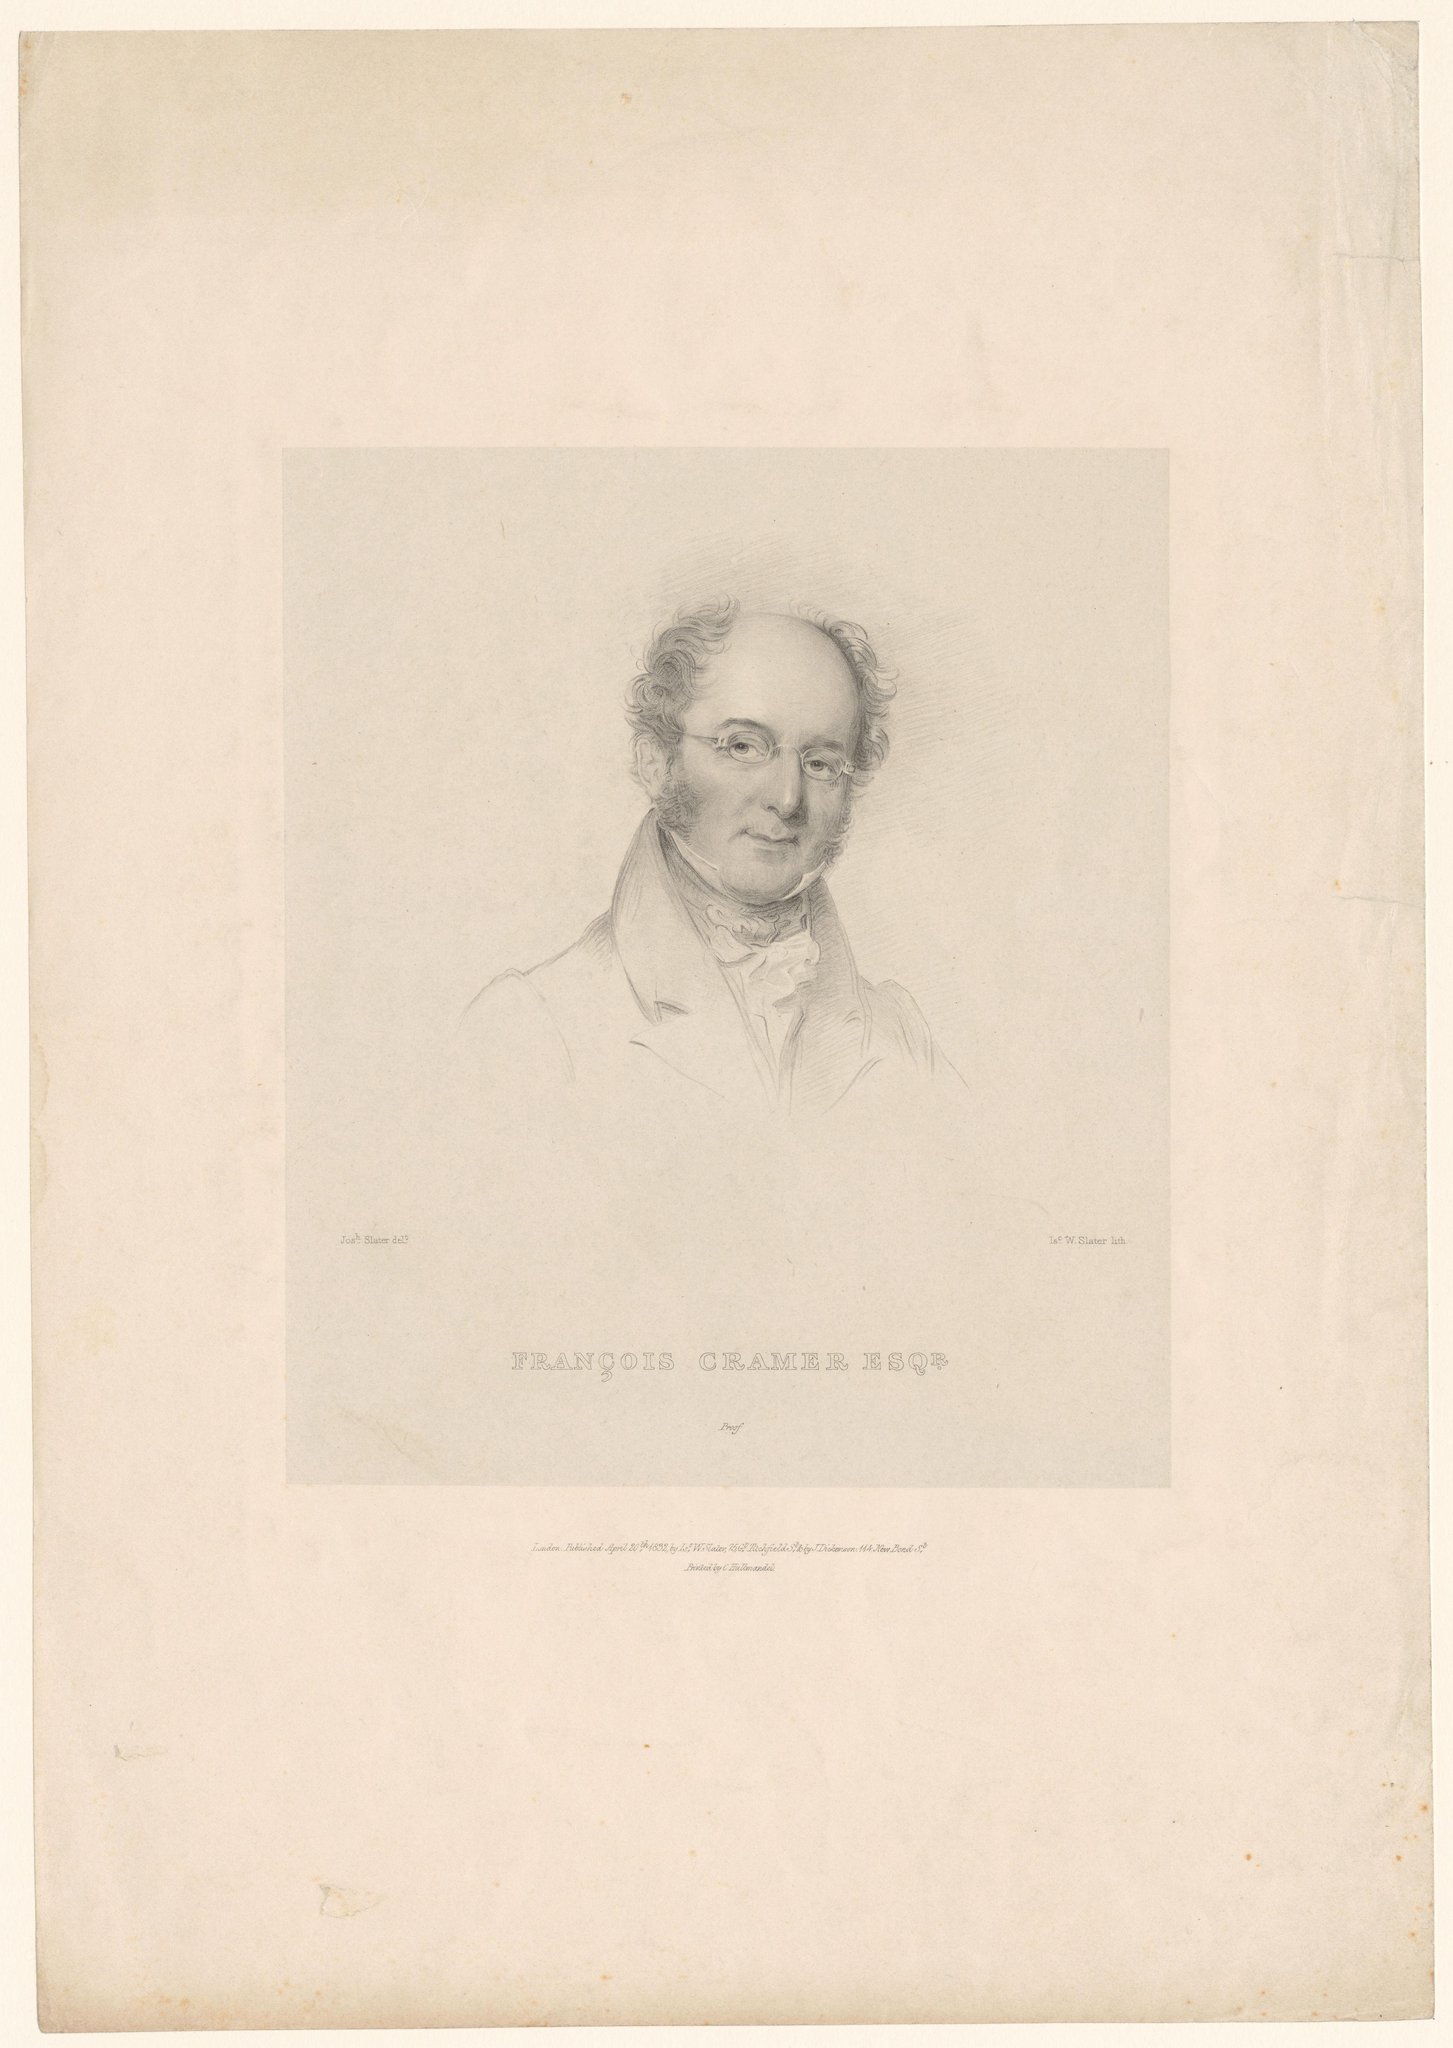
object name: print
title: Portret van Franz Cramer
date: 1832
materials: paper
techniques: lithograph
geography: london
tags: musician, eyeglasses, spectacles, adult man, historical persons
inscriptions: collector's mark: Lugt 2228